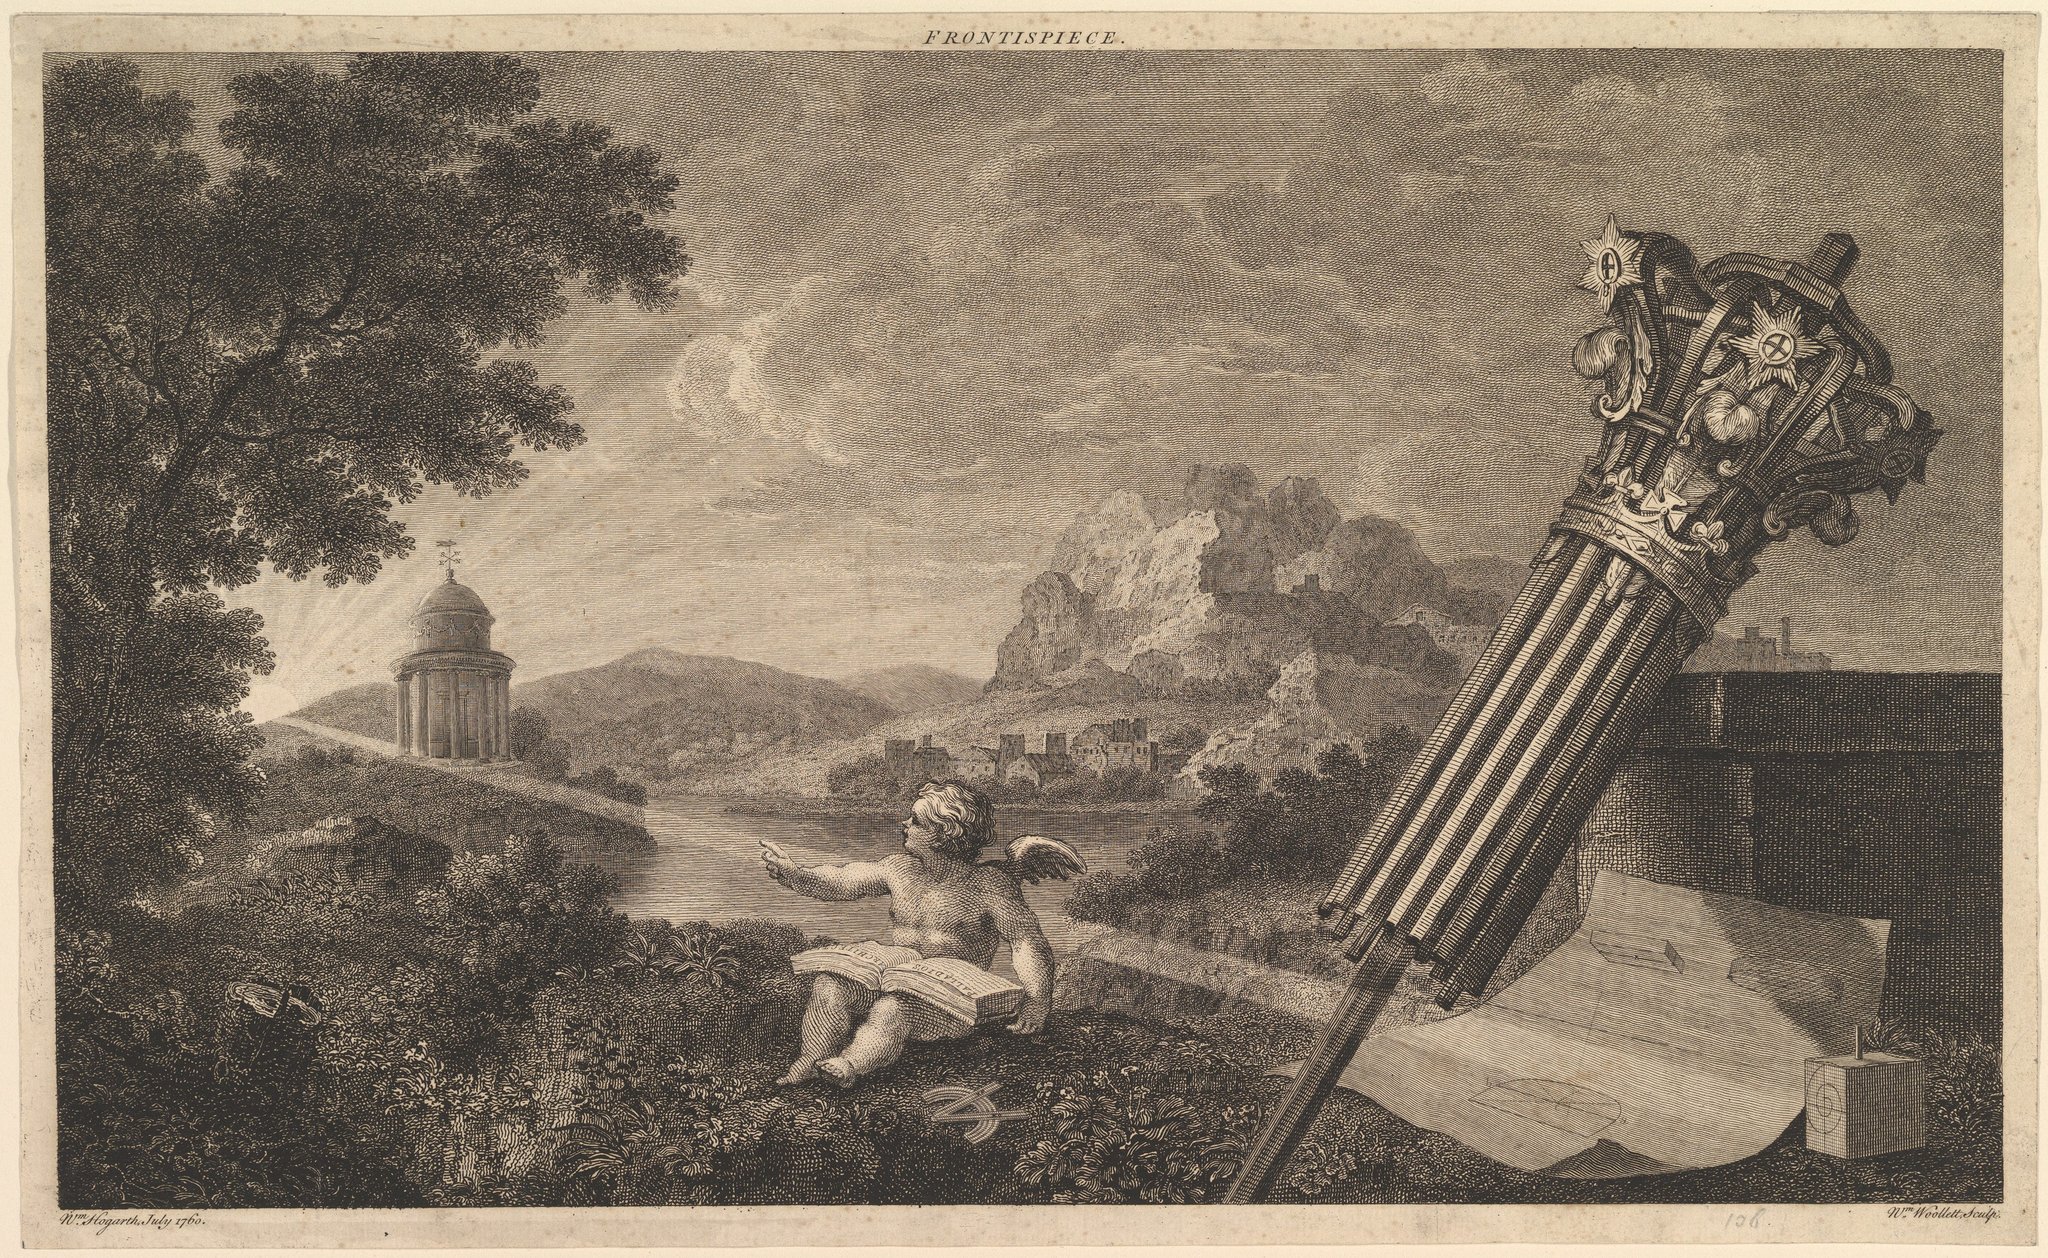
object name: print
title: Frontispiece to Joshua Kirby's "Perspective of Architecture" (1761)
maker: william woollett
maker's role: engraver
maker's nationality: british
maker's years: 1735-1785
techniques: etching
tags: columns,cupid